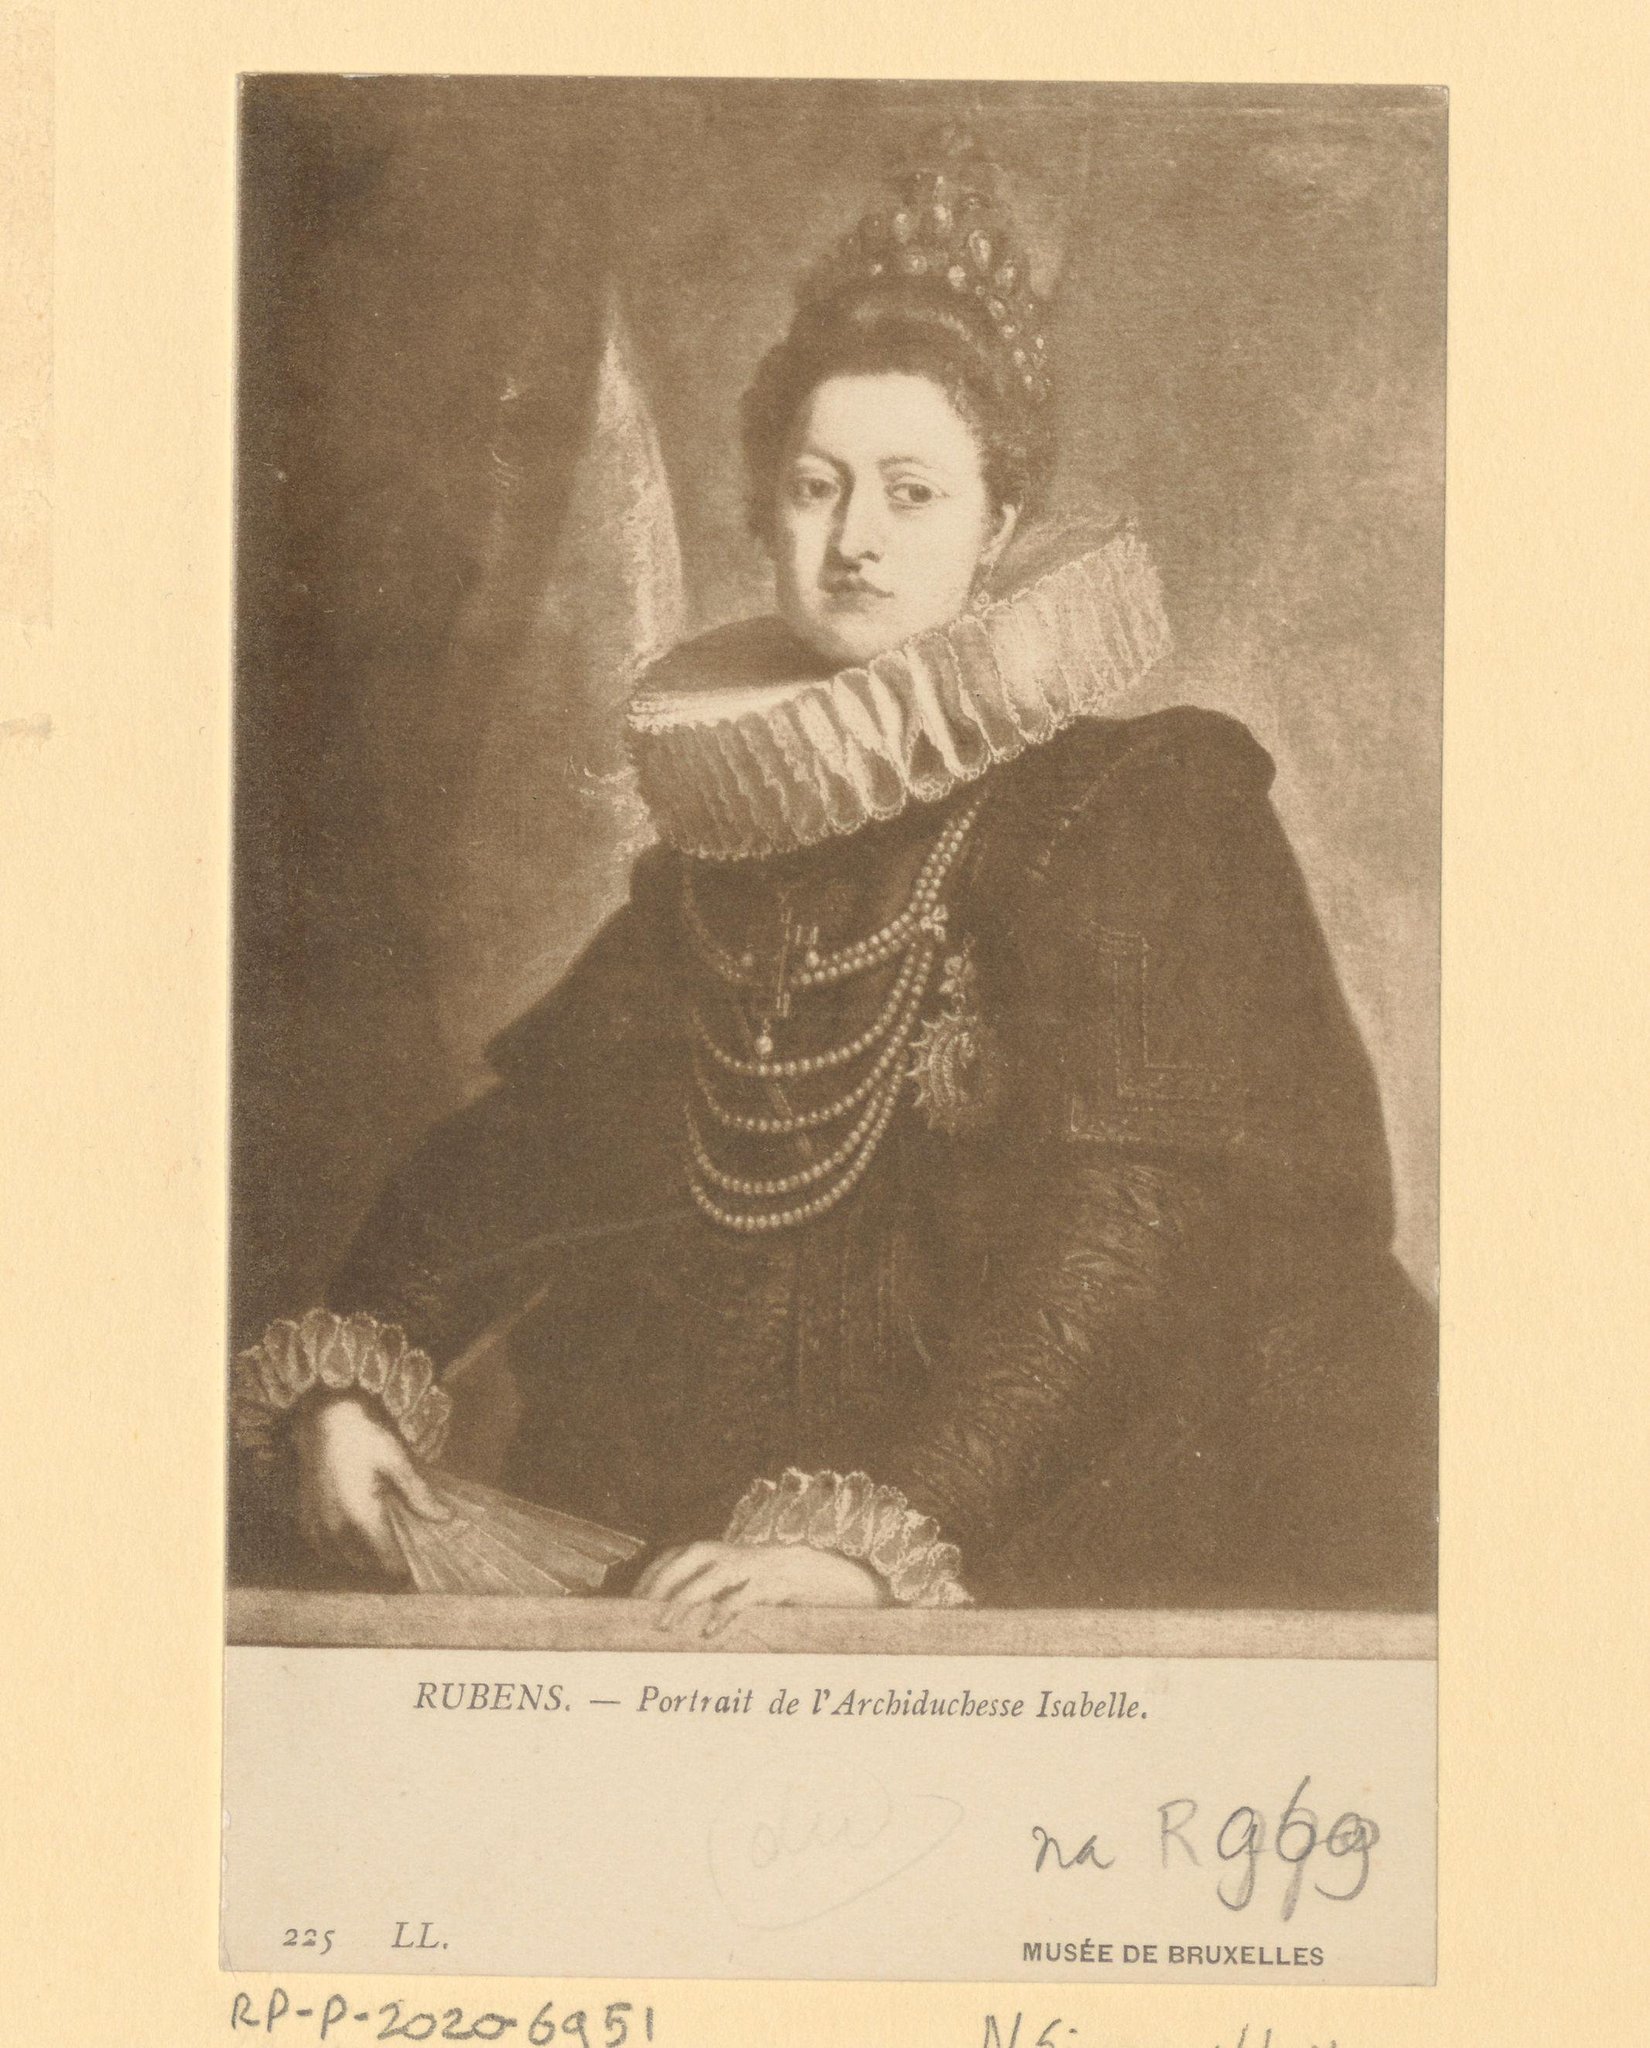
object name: photomechanical print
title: Portrait de l'Archiduchesse Isabelle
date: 1905-1930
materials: cardboard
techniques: photograph, letterpress printing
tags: infante van spanje isabella clara eugenia, historical persons - bb - woman, ruler, sovereign - bb - female ruler